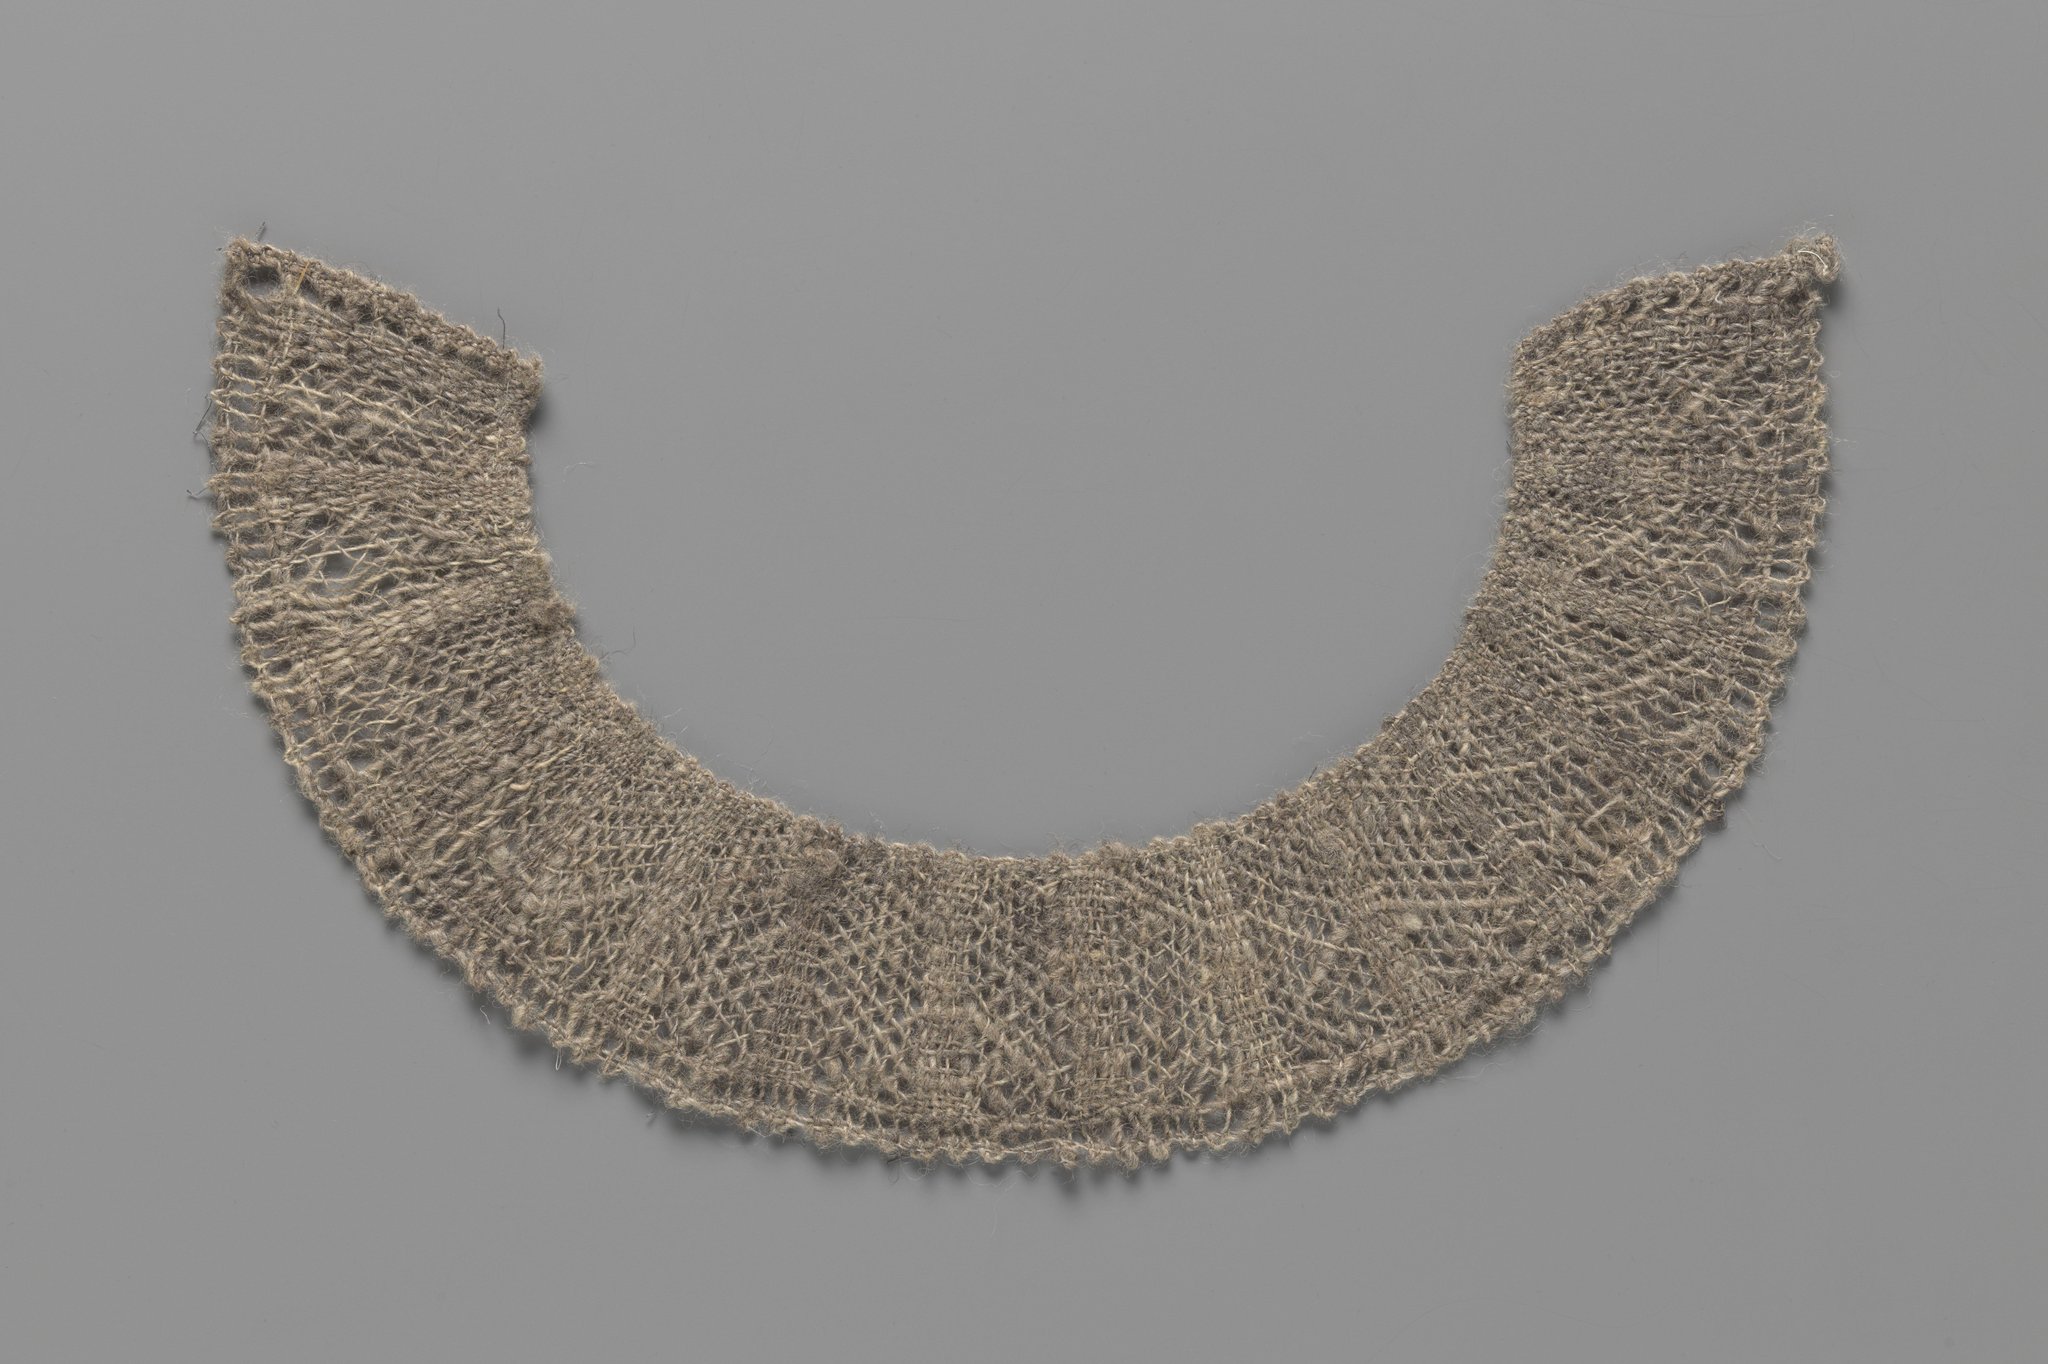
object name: collar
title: Kraag van kloskant gemaakt van grijze wol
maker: wilhelmina cornelia schutten-putters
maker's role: designer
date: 1925-1949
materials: wool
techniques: lace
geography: hoorn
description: Kraag van kloskant - Nederlandse kant - waarvoor ongeverfde en handgesponnen wol van een grijs gekleurd schaap is gebruikt. Halfcirkelvormig model. Het zich herhalende patroon bestaat uit straalsgewijs geplaatste banen die afwisselend zijn gemaakt in linnenslag en netslag. Langs de buitenzijde en korte zijden is de kraag afgewerkt met een open picotrand. De kraag is gemaakt door mevrouw Schutten-Putters, directrice van kantklosvereniging Het Molenwiekje. De vereniging had een 'wolkantafdeling' genaamd 't Web, die zich specialiseerde in het kantklossen met wol.